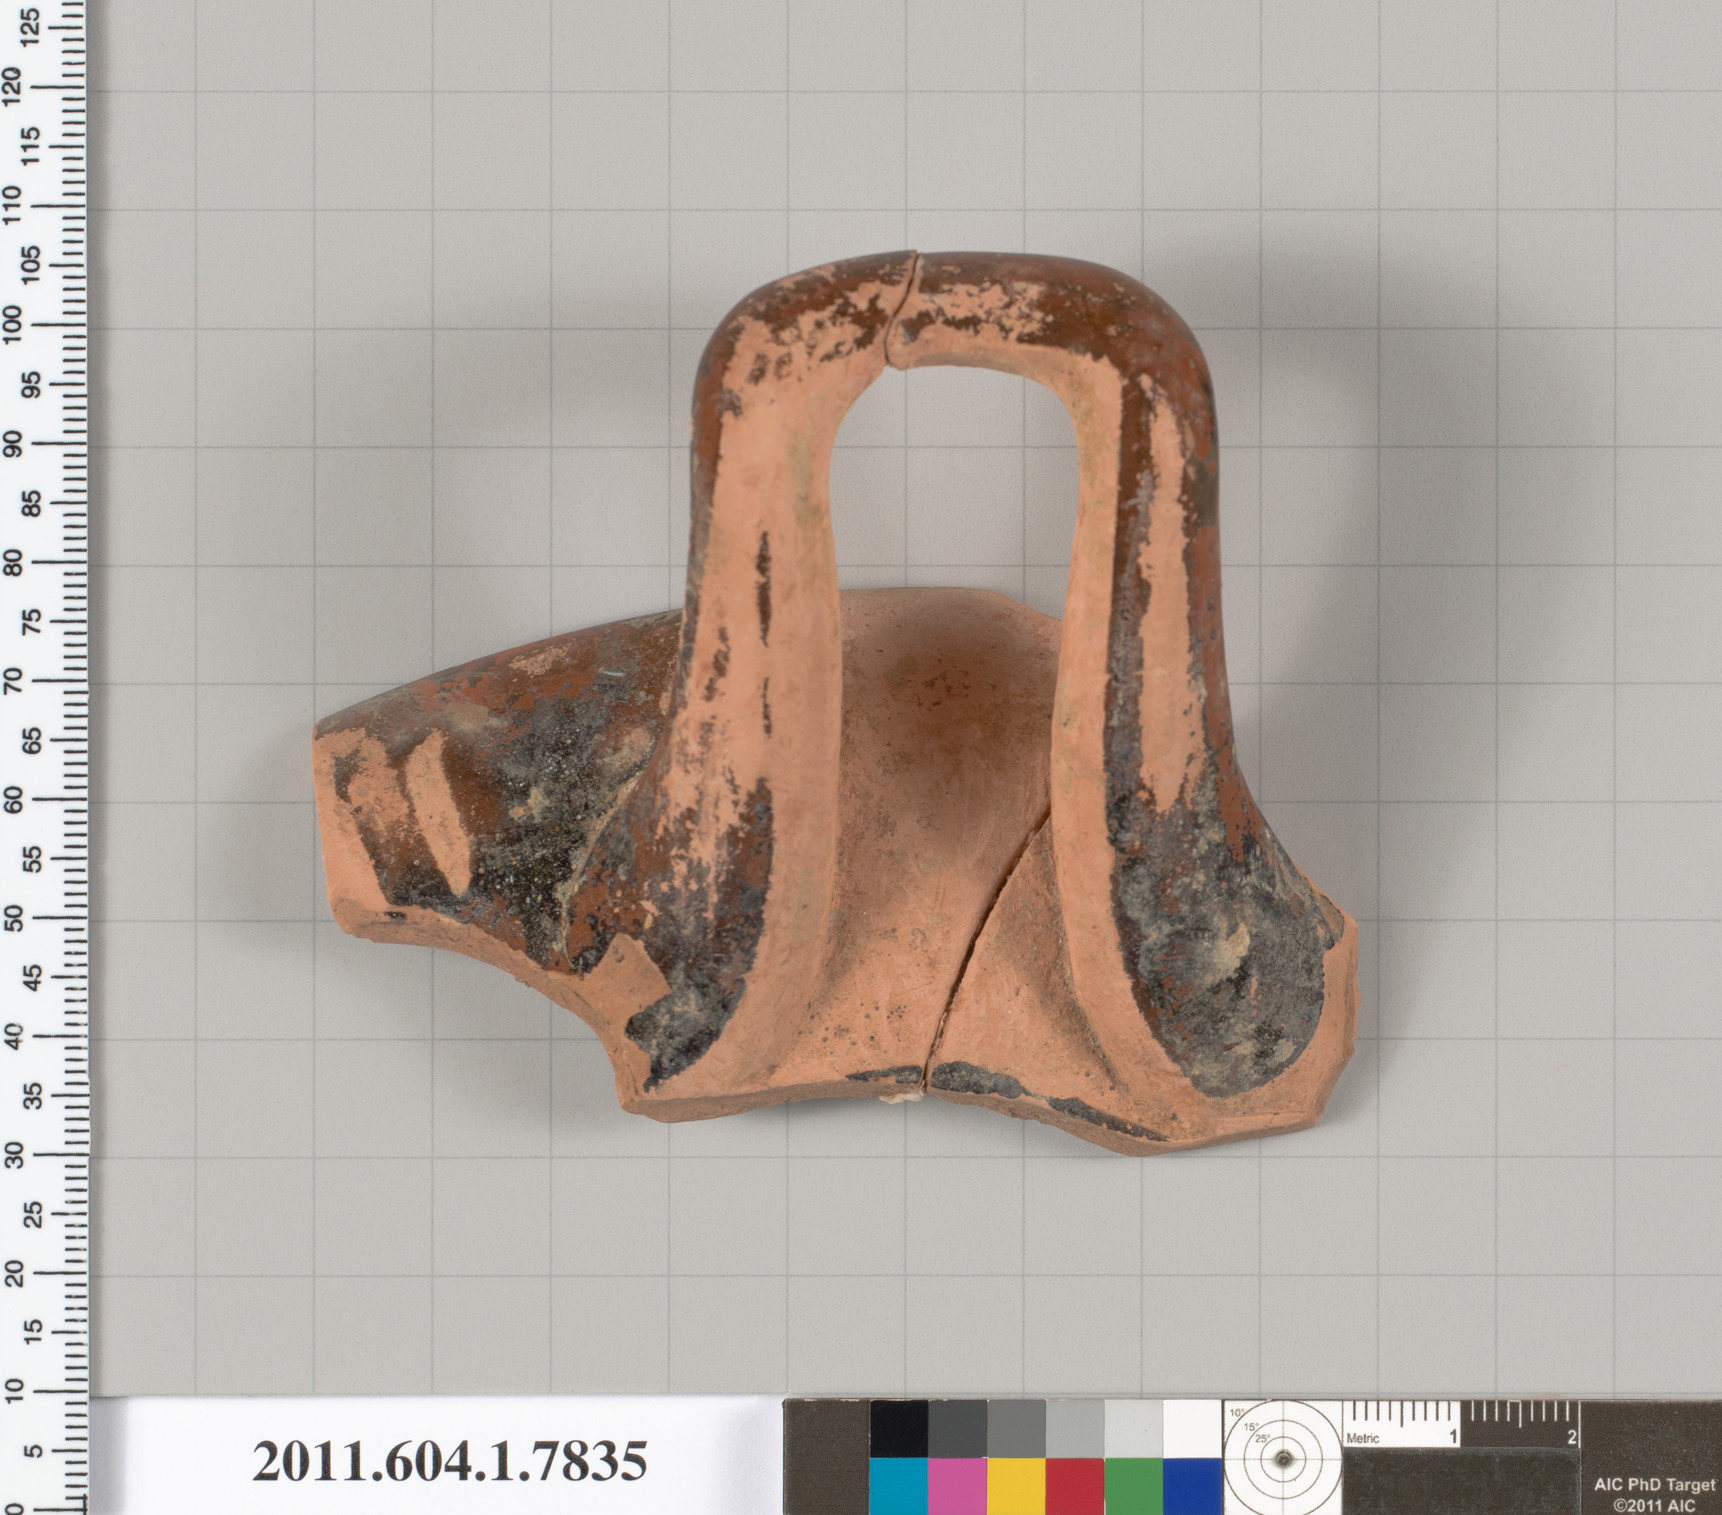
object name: kylix fragment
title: Terracotta fragment of a kylix (drinking cup)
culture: greek, attic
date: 460-450 BCE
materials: terracotta